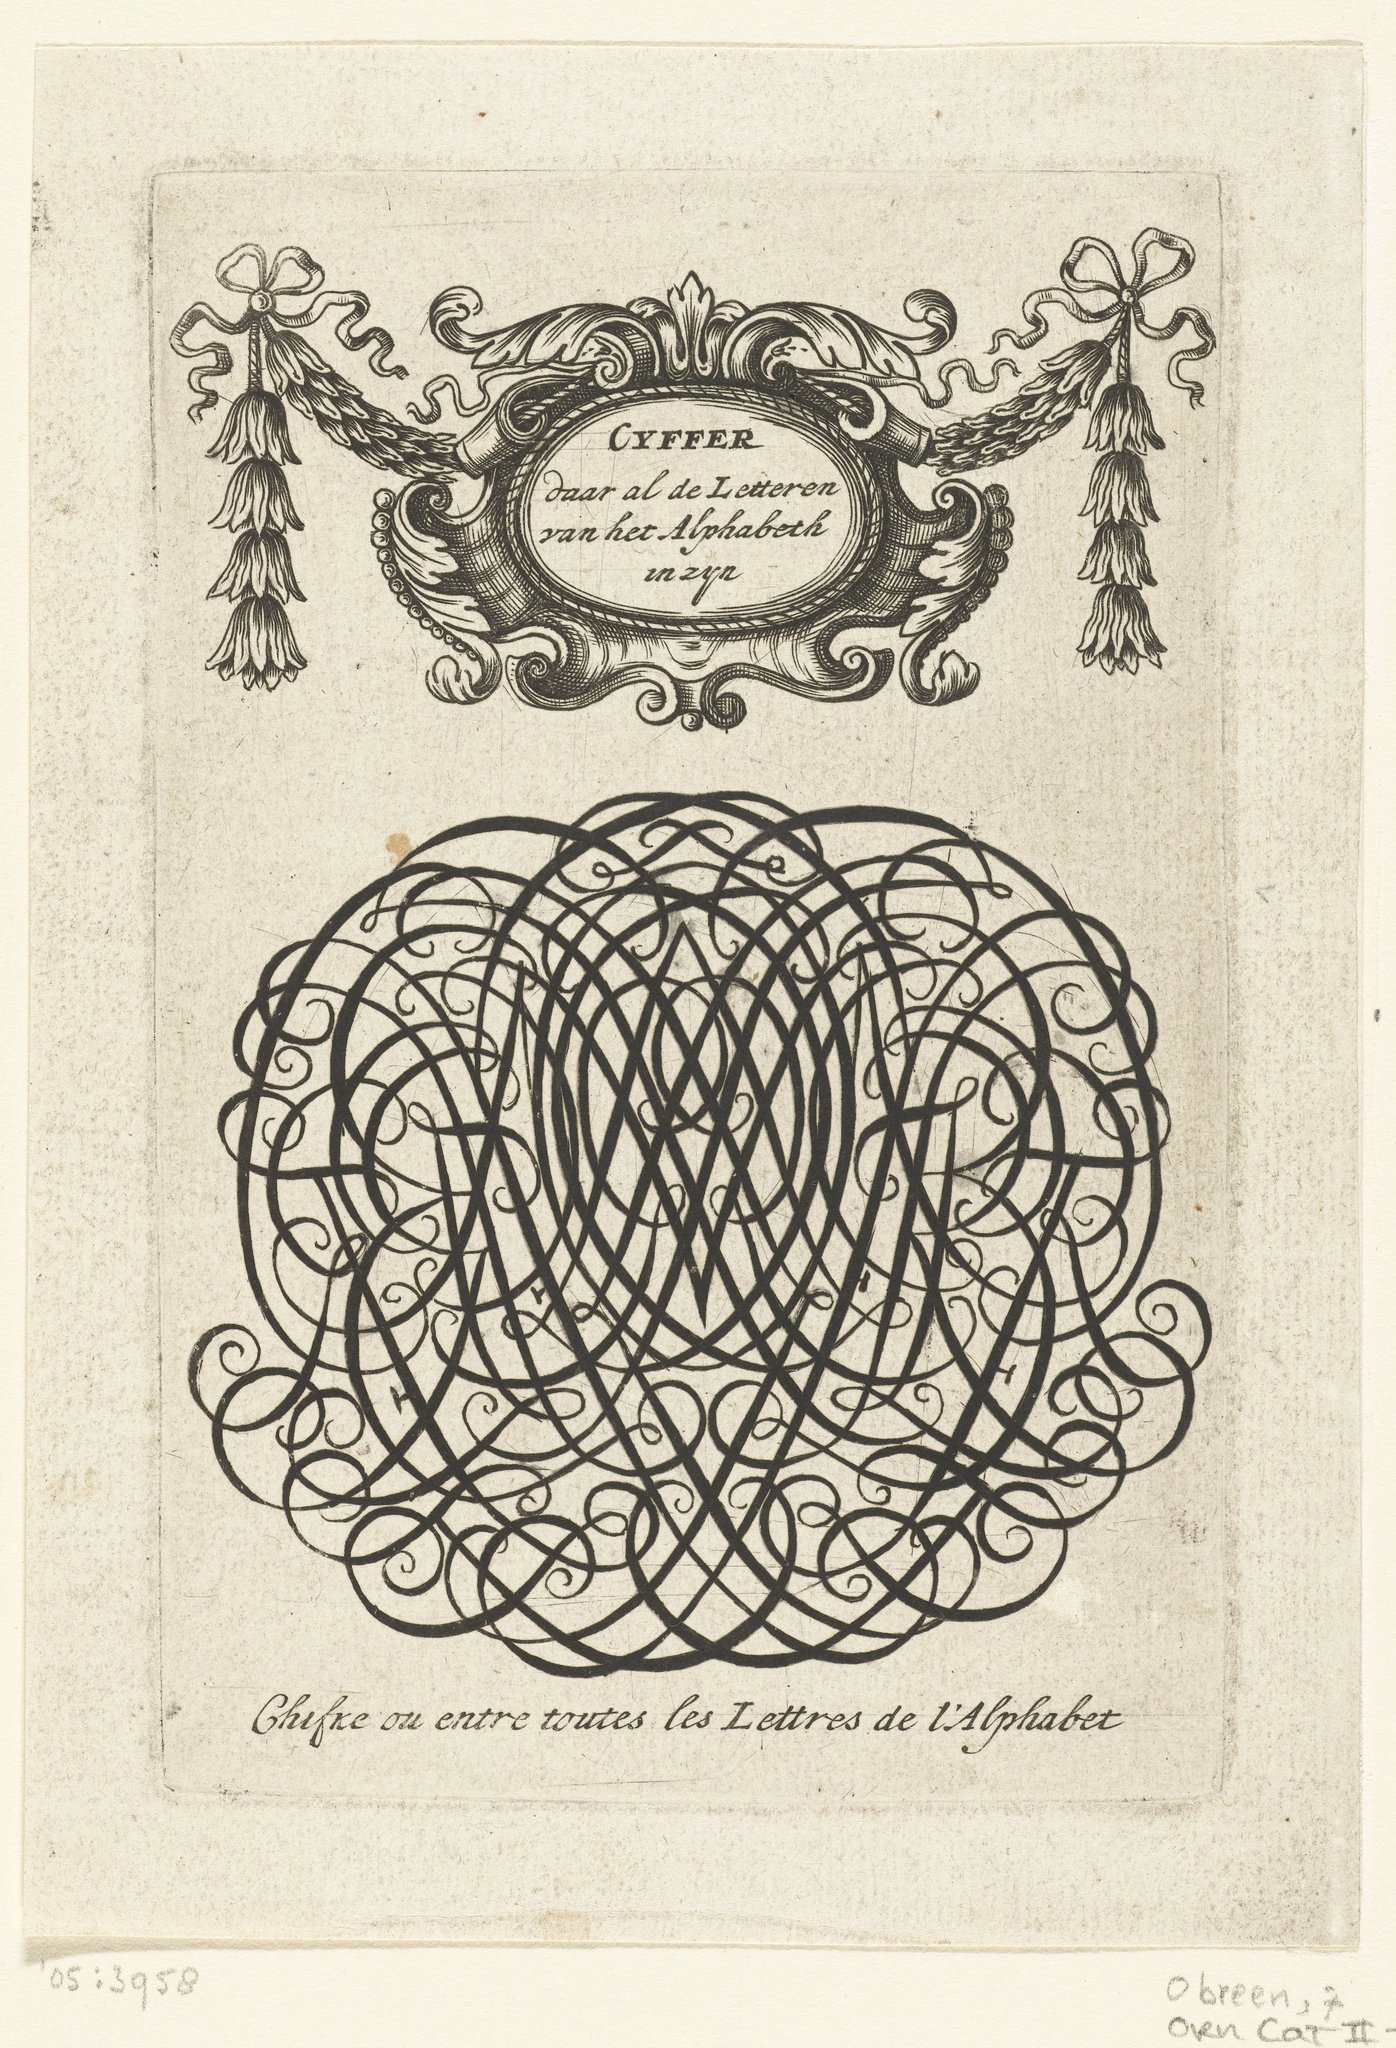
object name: print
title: Cartouche boven een monogram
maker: daniel de lafeuille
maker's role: print maker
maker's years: 1640-1709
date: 1690-1691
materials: paper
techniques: engraving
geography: amsterdam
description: Uit serie van 29 deels genummerde bladen met cijfermonogrammen.